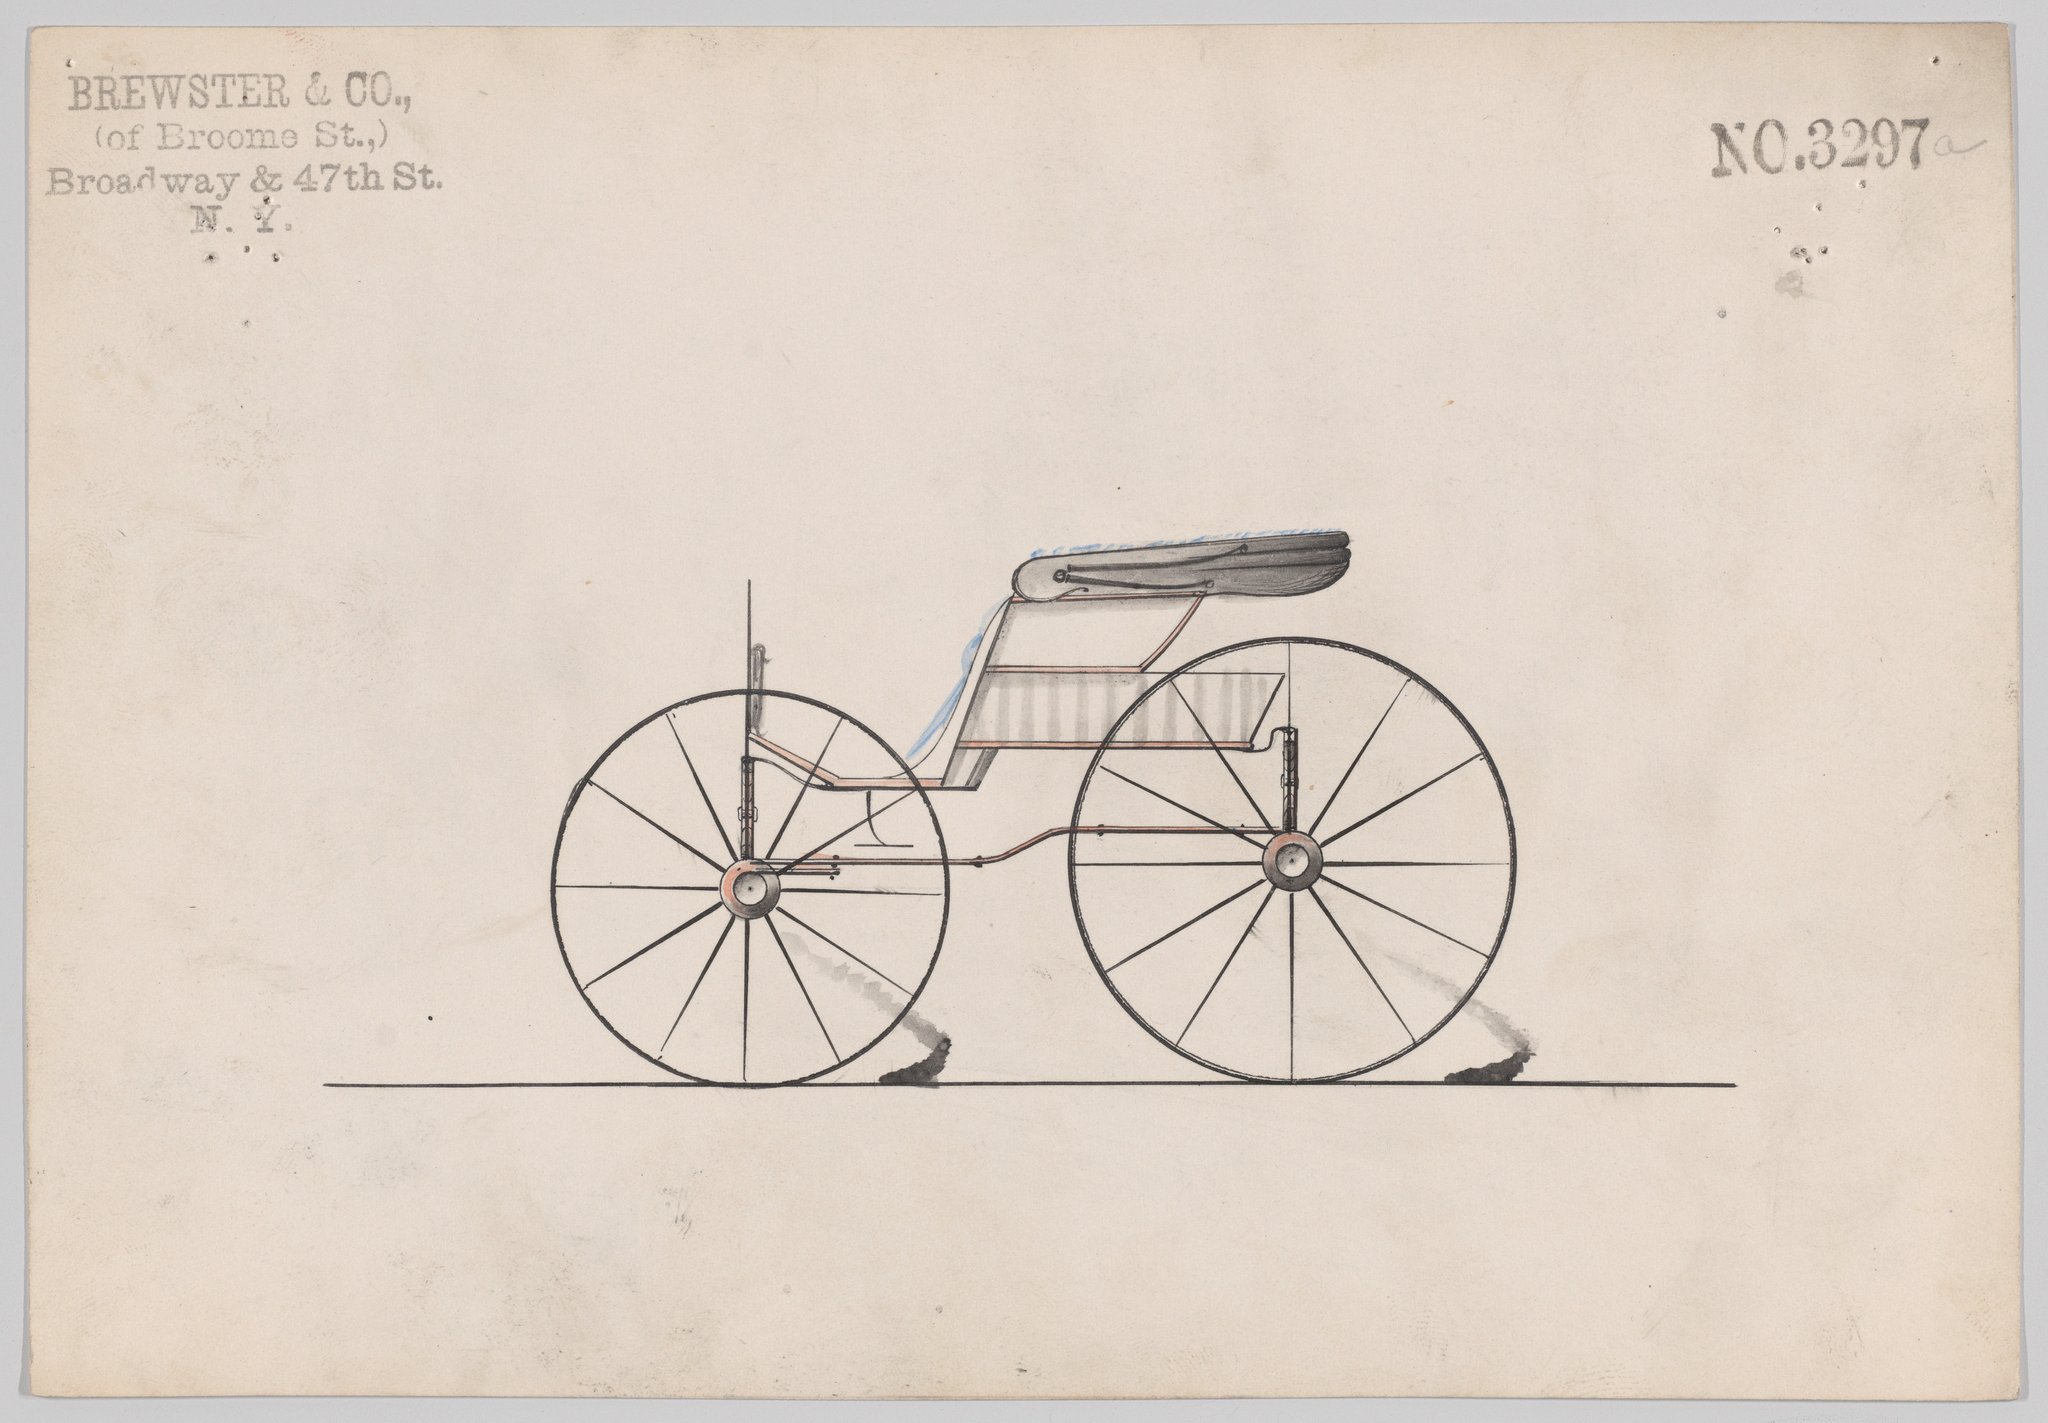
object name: drawing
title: Design for Pony Phaeton, no. 3297a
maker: brewster & co.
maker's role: manufacturer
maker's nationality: american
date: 1877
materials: gouache, ink, watercolor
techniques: pen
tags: carriages